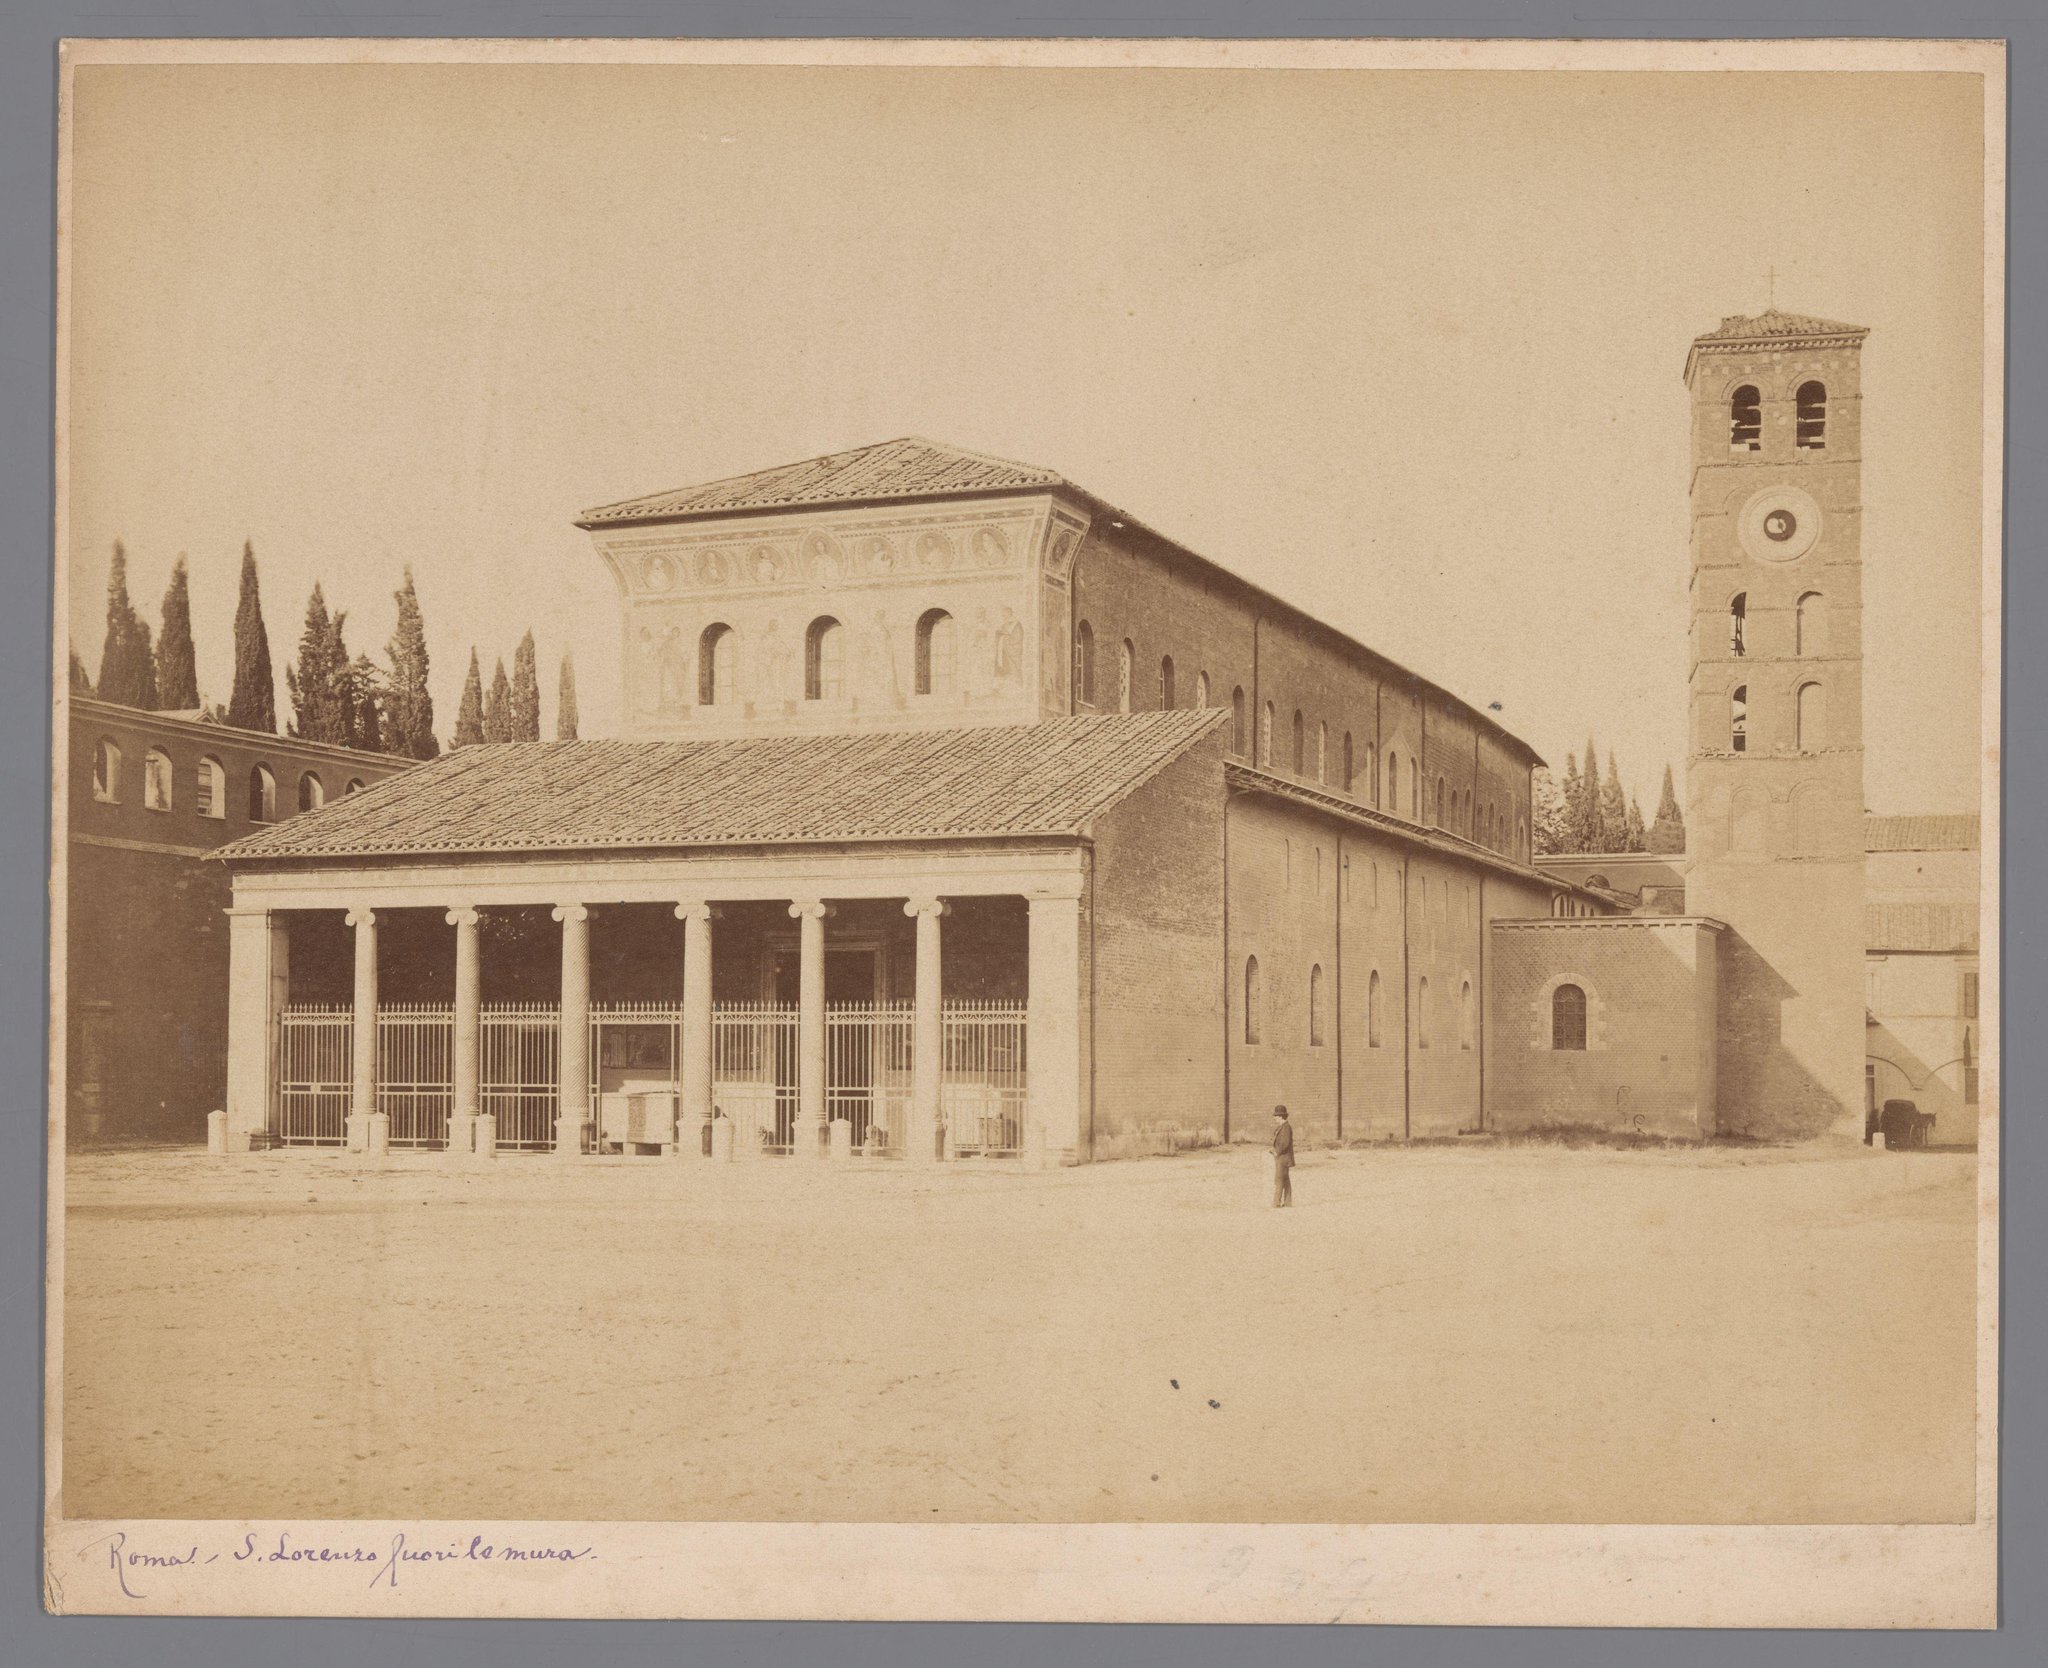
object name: photograph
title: Exterieur van de Sint-Laurens buiten de Muren te Rome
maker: Anonymous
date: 1851-1900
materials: cardboard, paper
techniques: albumen print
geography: rome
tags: parts of church exterior and annexes: campanile, church (exterior)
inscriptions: annotation: ‘Roma - S. Lorenzo fuori le mura’